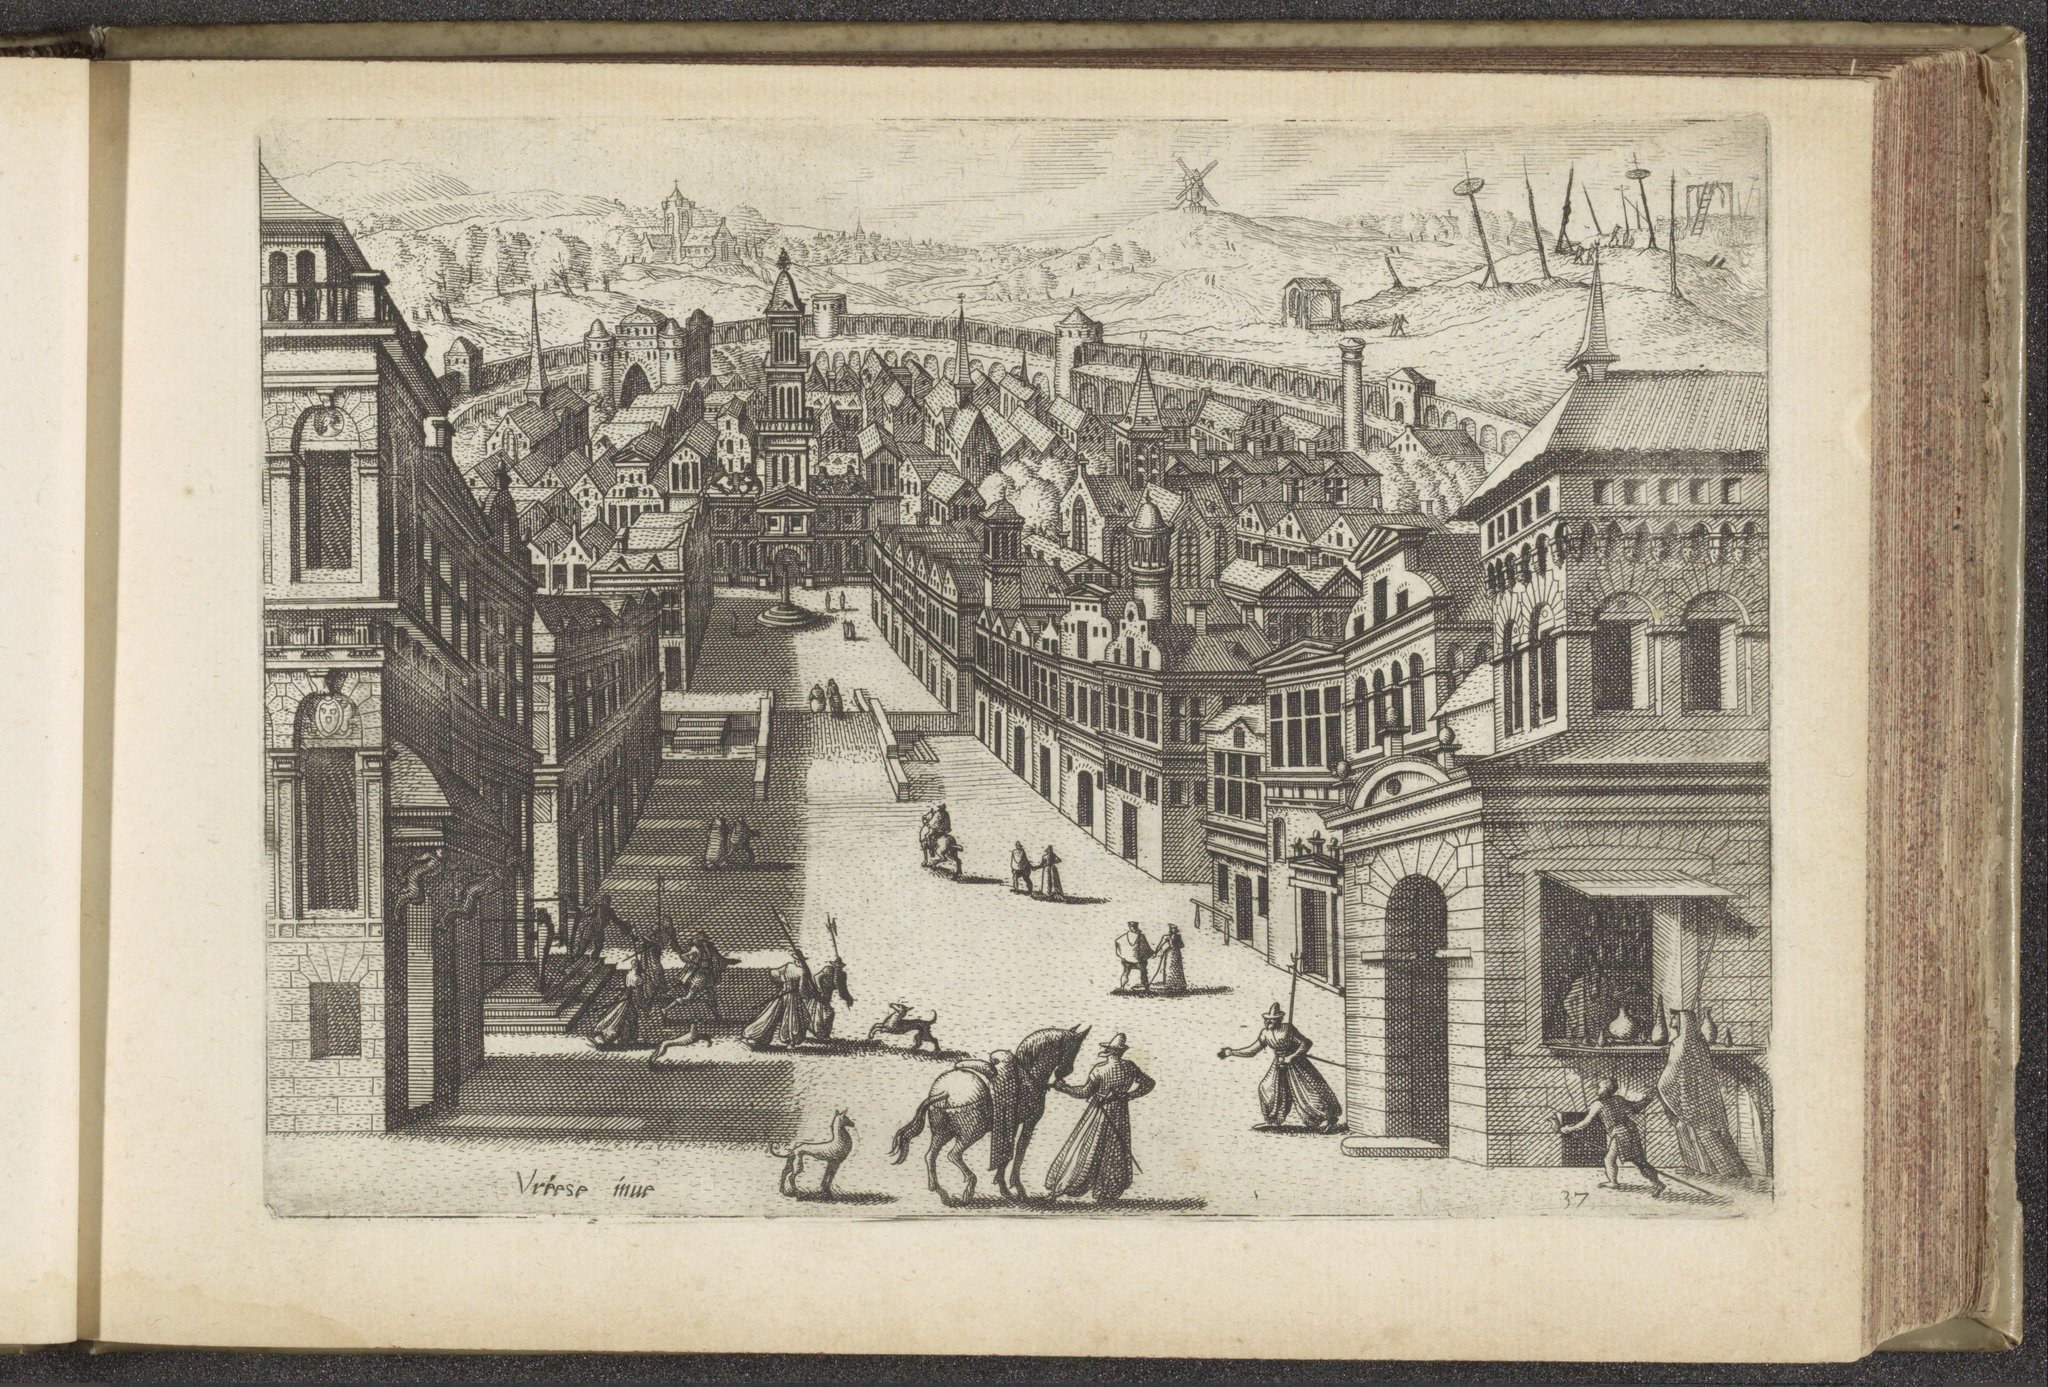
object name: album leaf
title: Kleine architecturale perspectief gezichten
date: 1562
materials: paper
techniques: etching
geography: antwerp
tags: city-view, and landscape with man-made constructions, tower, clock tower ~ monumental adornment, architectural representations in general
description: Gezicht op een aflopende straat en een ommuurde stad. In de straat figuren. Aan het einde van de straat een toren. Rechts op de achtergrond een galgenveld. Deze prent maakt deel uit van een album.